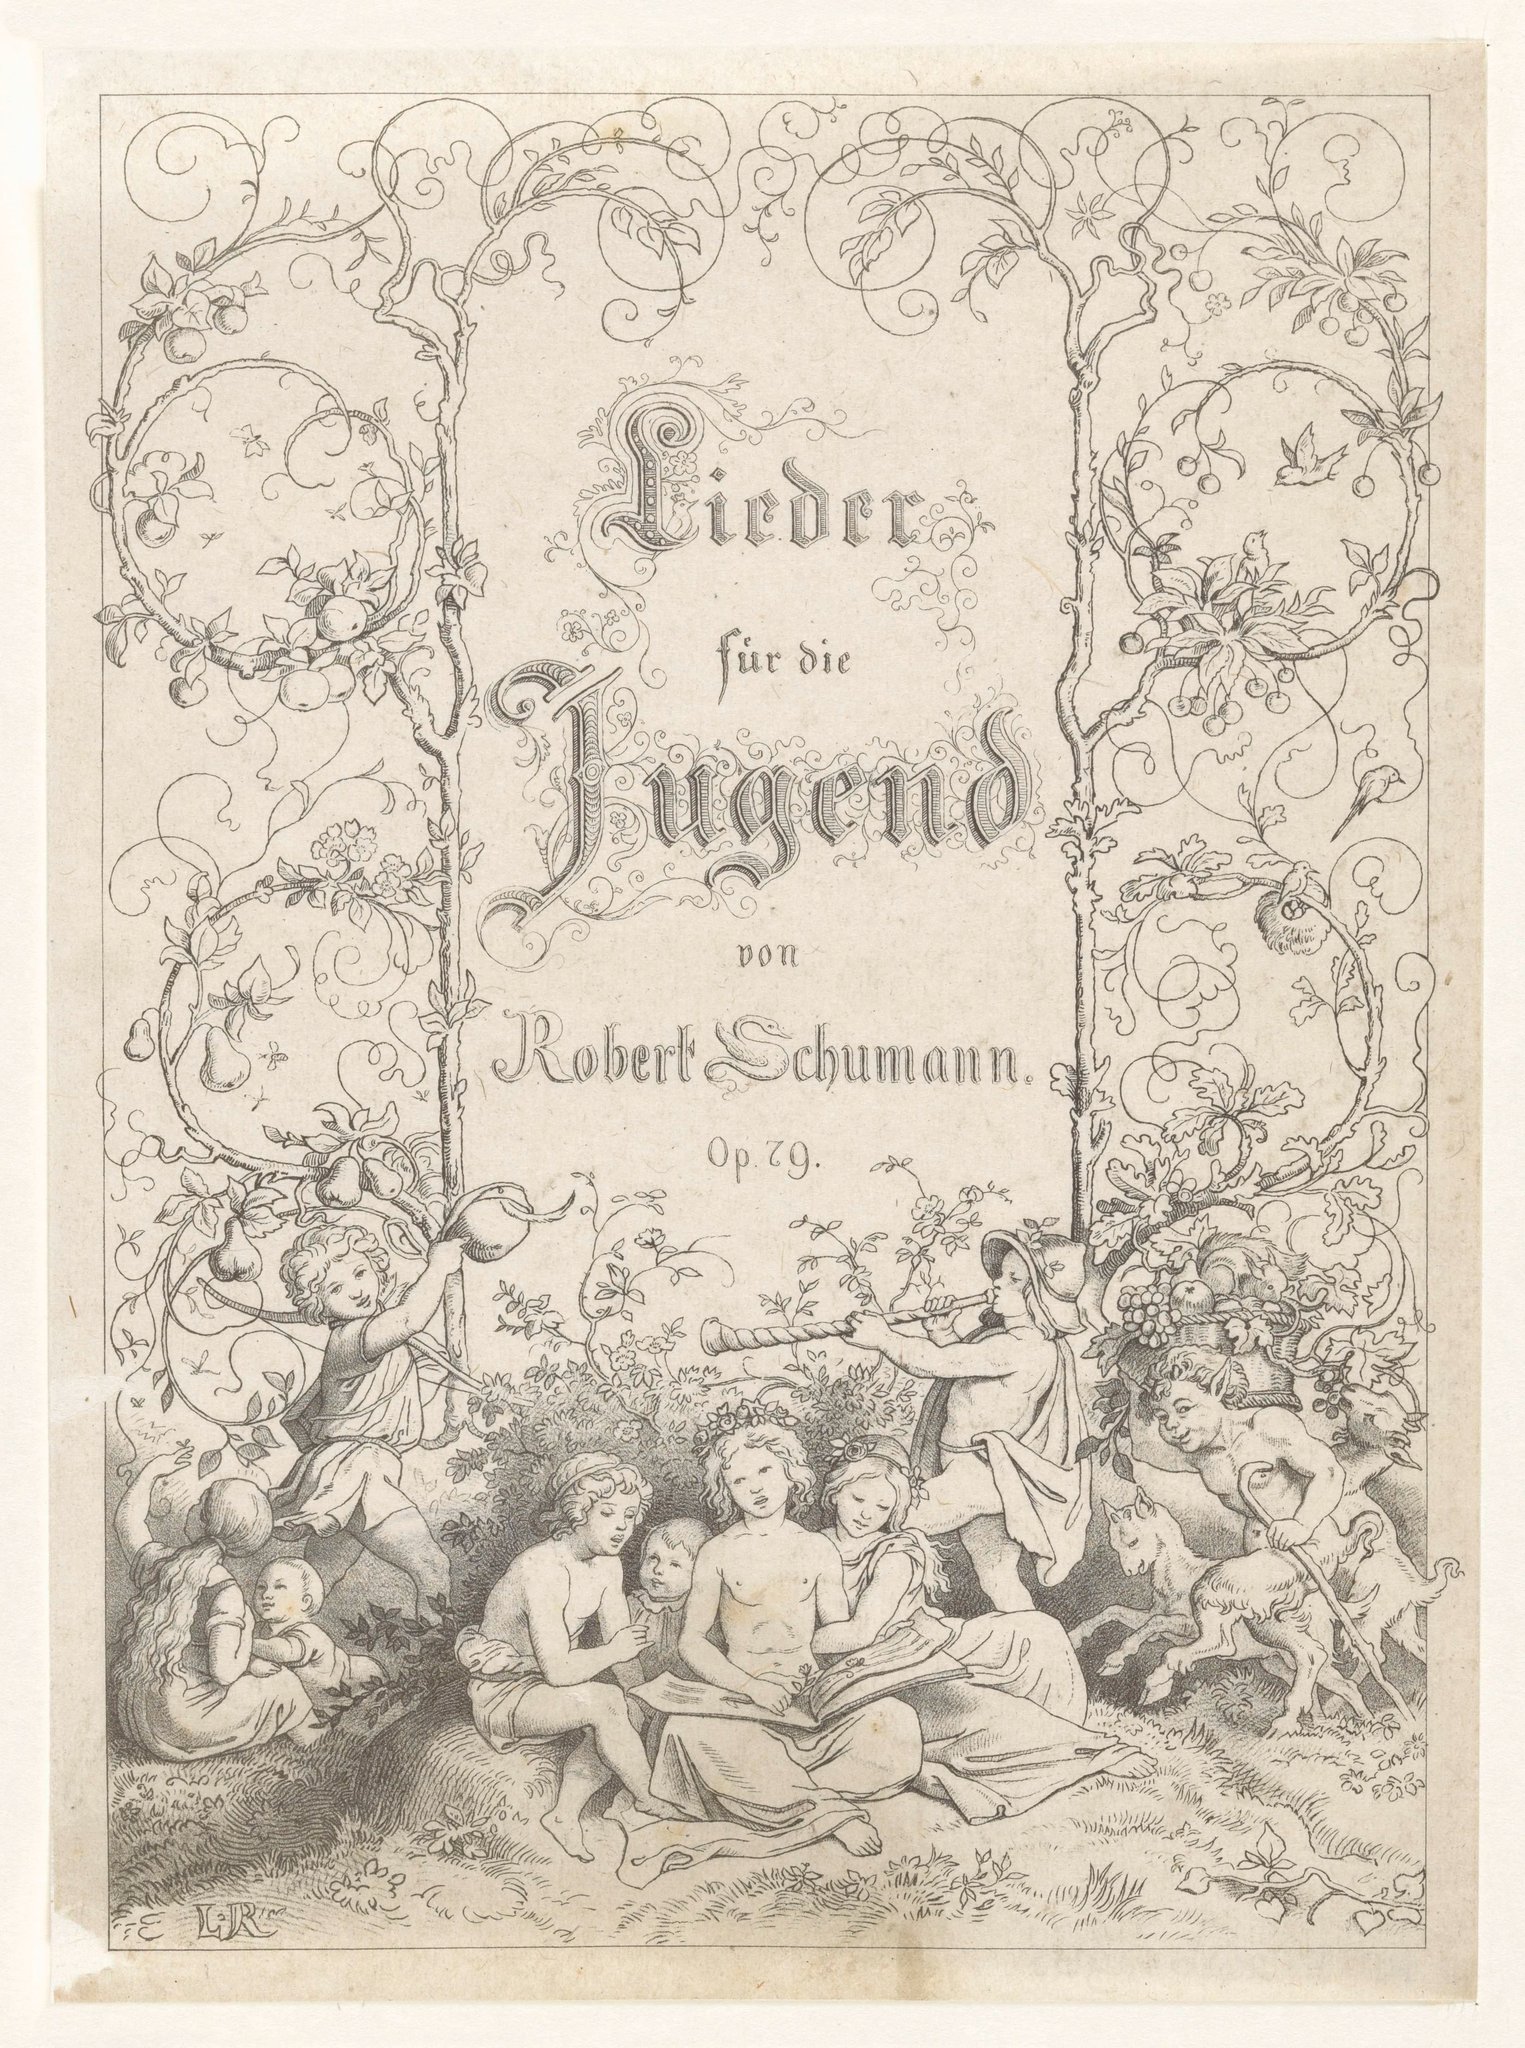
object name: titelblad, titelpagina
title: Lieder für die Jugend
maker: Anonymous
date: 1849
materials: paper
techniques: etching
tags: children singing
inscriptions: collector's mark: Lugt 2228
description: Vier kinderen zingen zittend op de grond met een boek op schoot. Links staat een kind als jager en zitten twee kinderen. Rechts loopt een kind met een blaasinstrument en een sater met twee bokken. Aan de bovenzijde de titel omgeven door ranken met fruit en vogels.